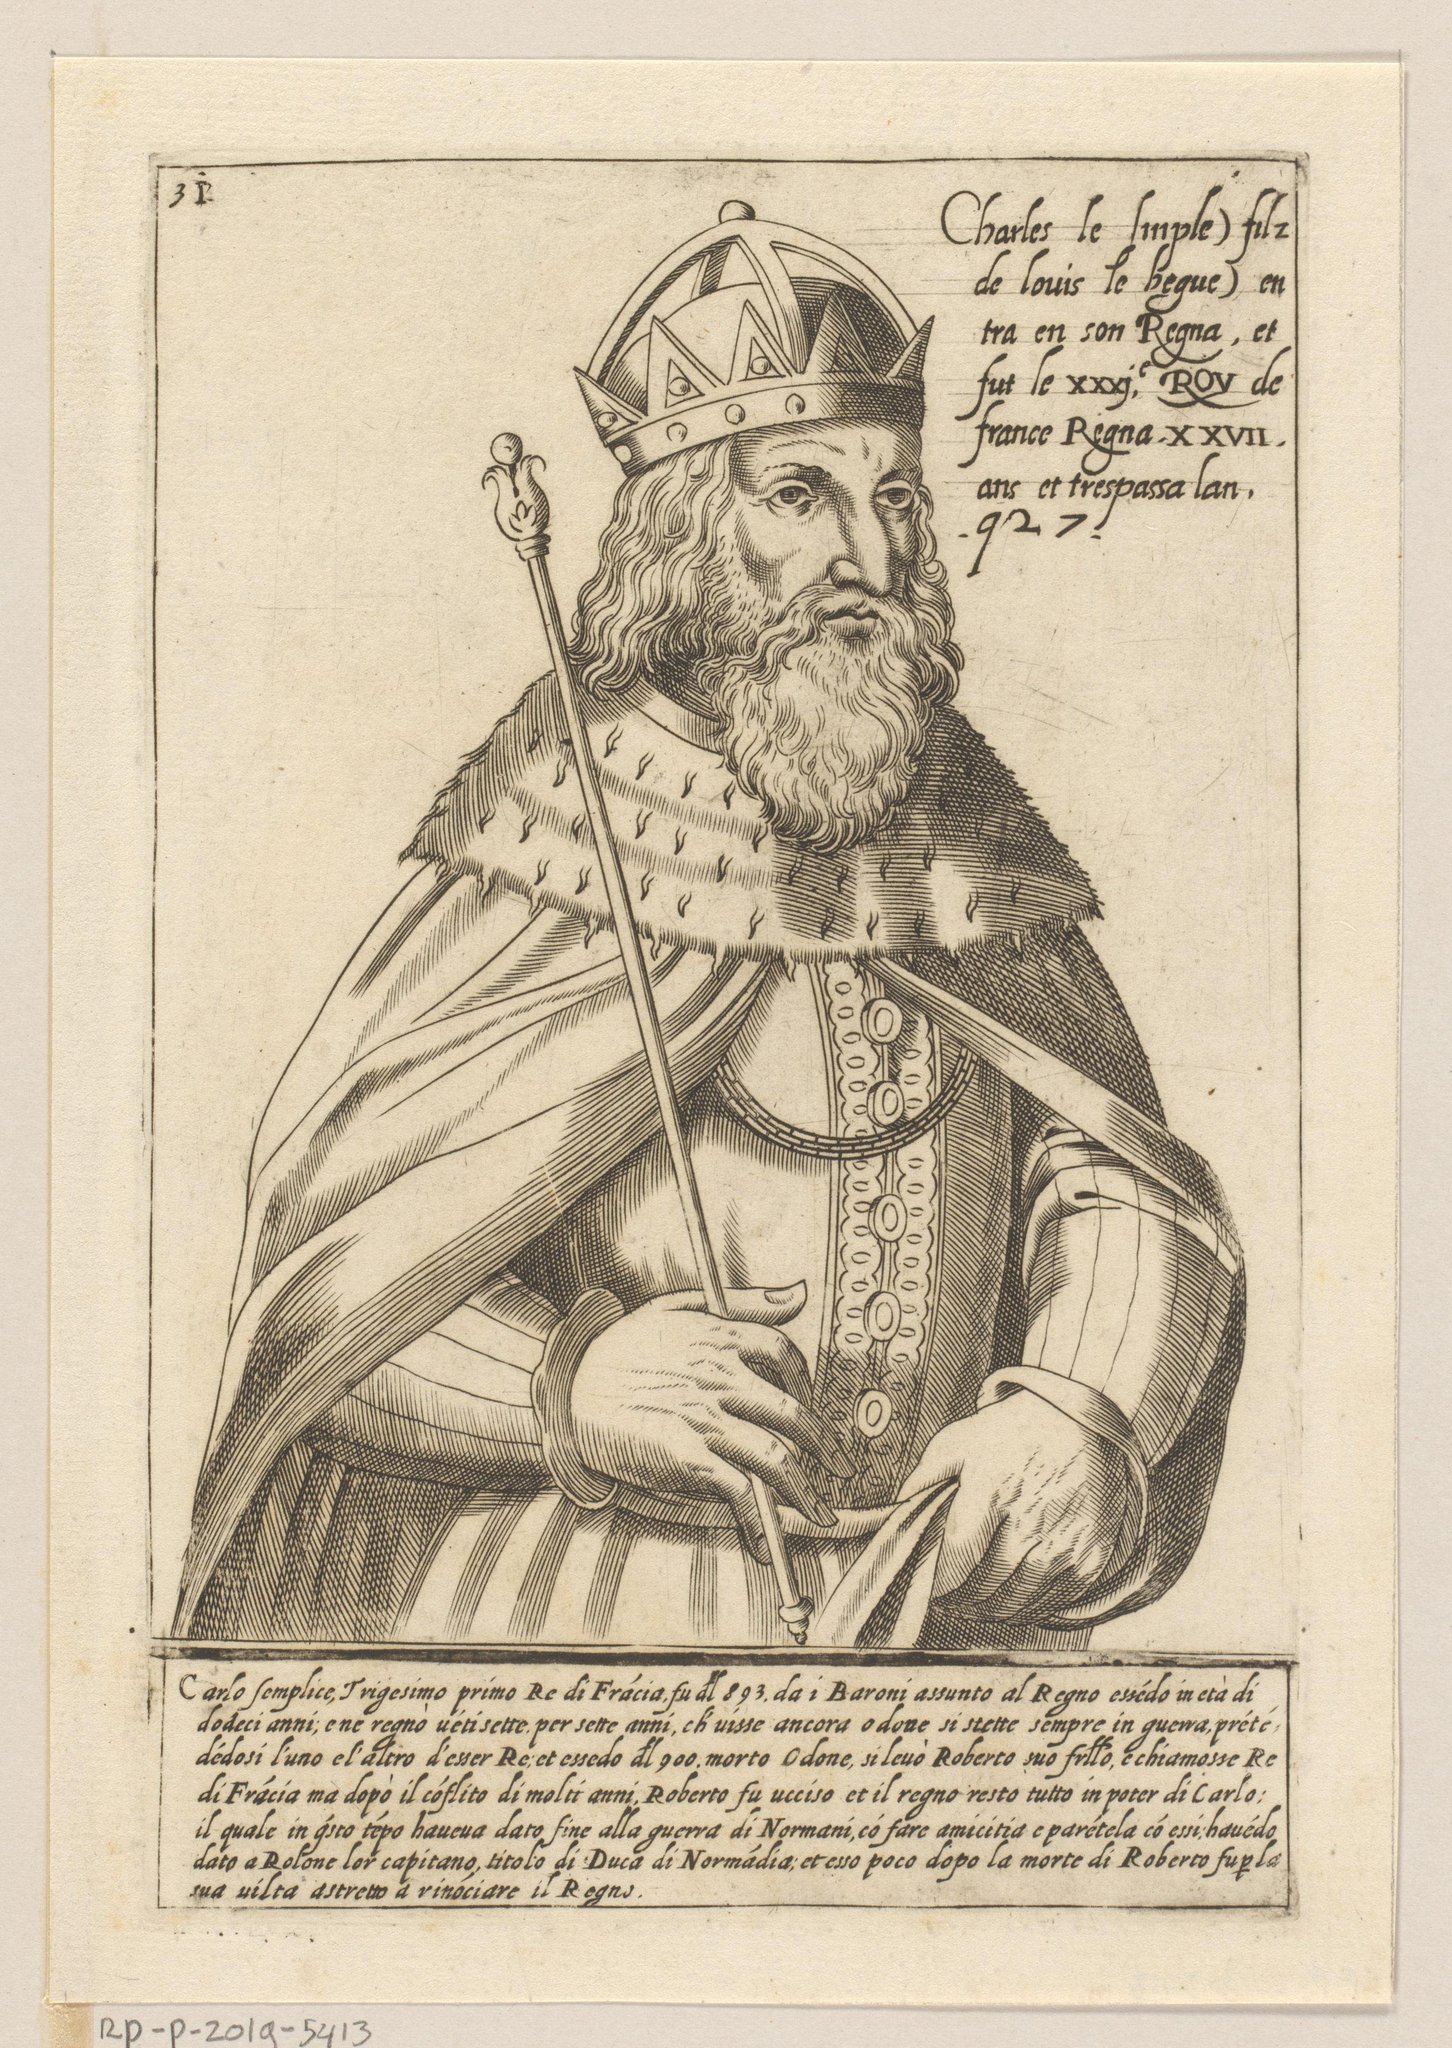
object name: print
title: Portret van Karel de Eenvoudige, koning van West-Francië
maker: Anonymous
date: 1588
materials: paper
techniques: engraving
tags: crown (symbol of sovereignty), sceptre, staff (symbol of sovereignty), historical persons, king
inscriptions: watermark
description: Prent voor het eerst gebruikt in: Cronica Breve de i fatti illustri de're di Francia, con le loro effigie dal naturale cominciando da Faramondo (...). Venetië: Bernardo Giunti, 1588. Prent in ieder geval ook gebruikt in de editie van 1590 en mogelijk ook in een Franse uitgave van 1597.